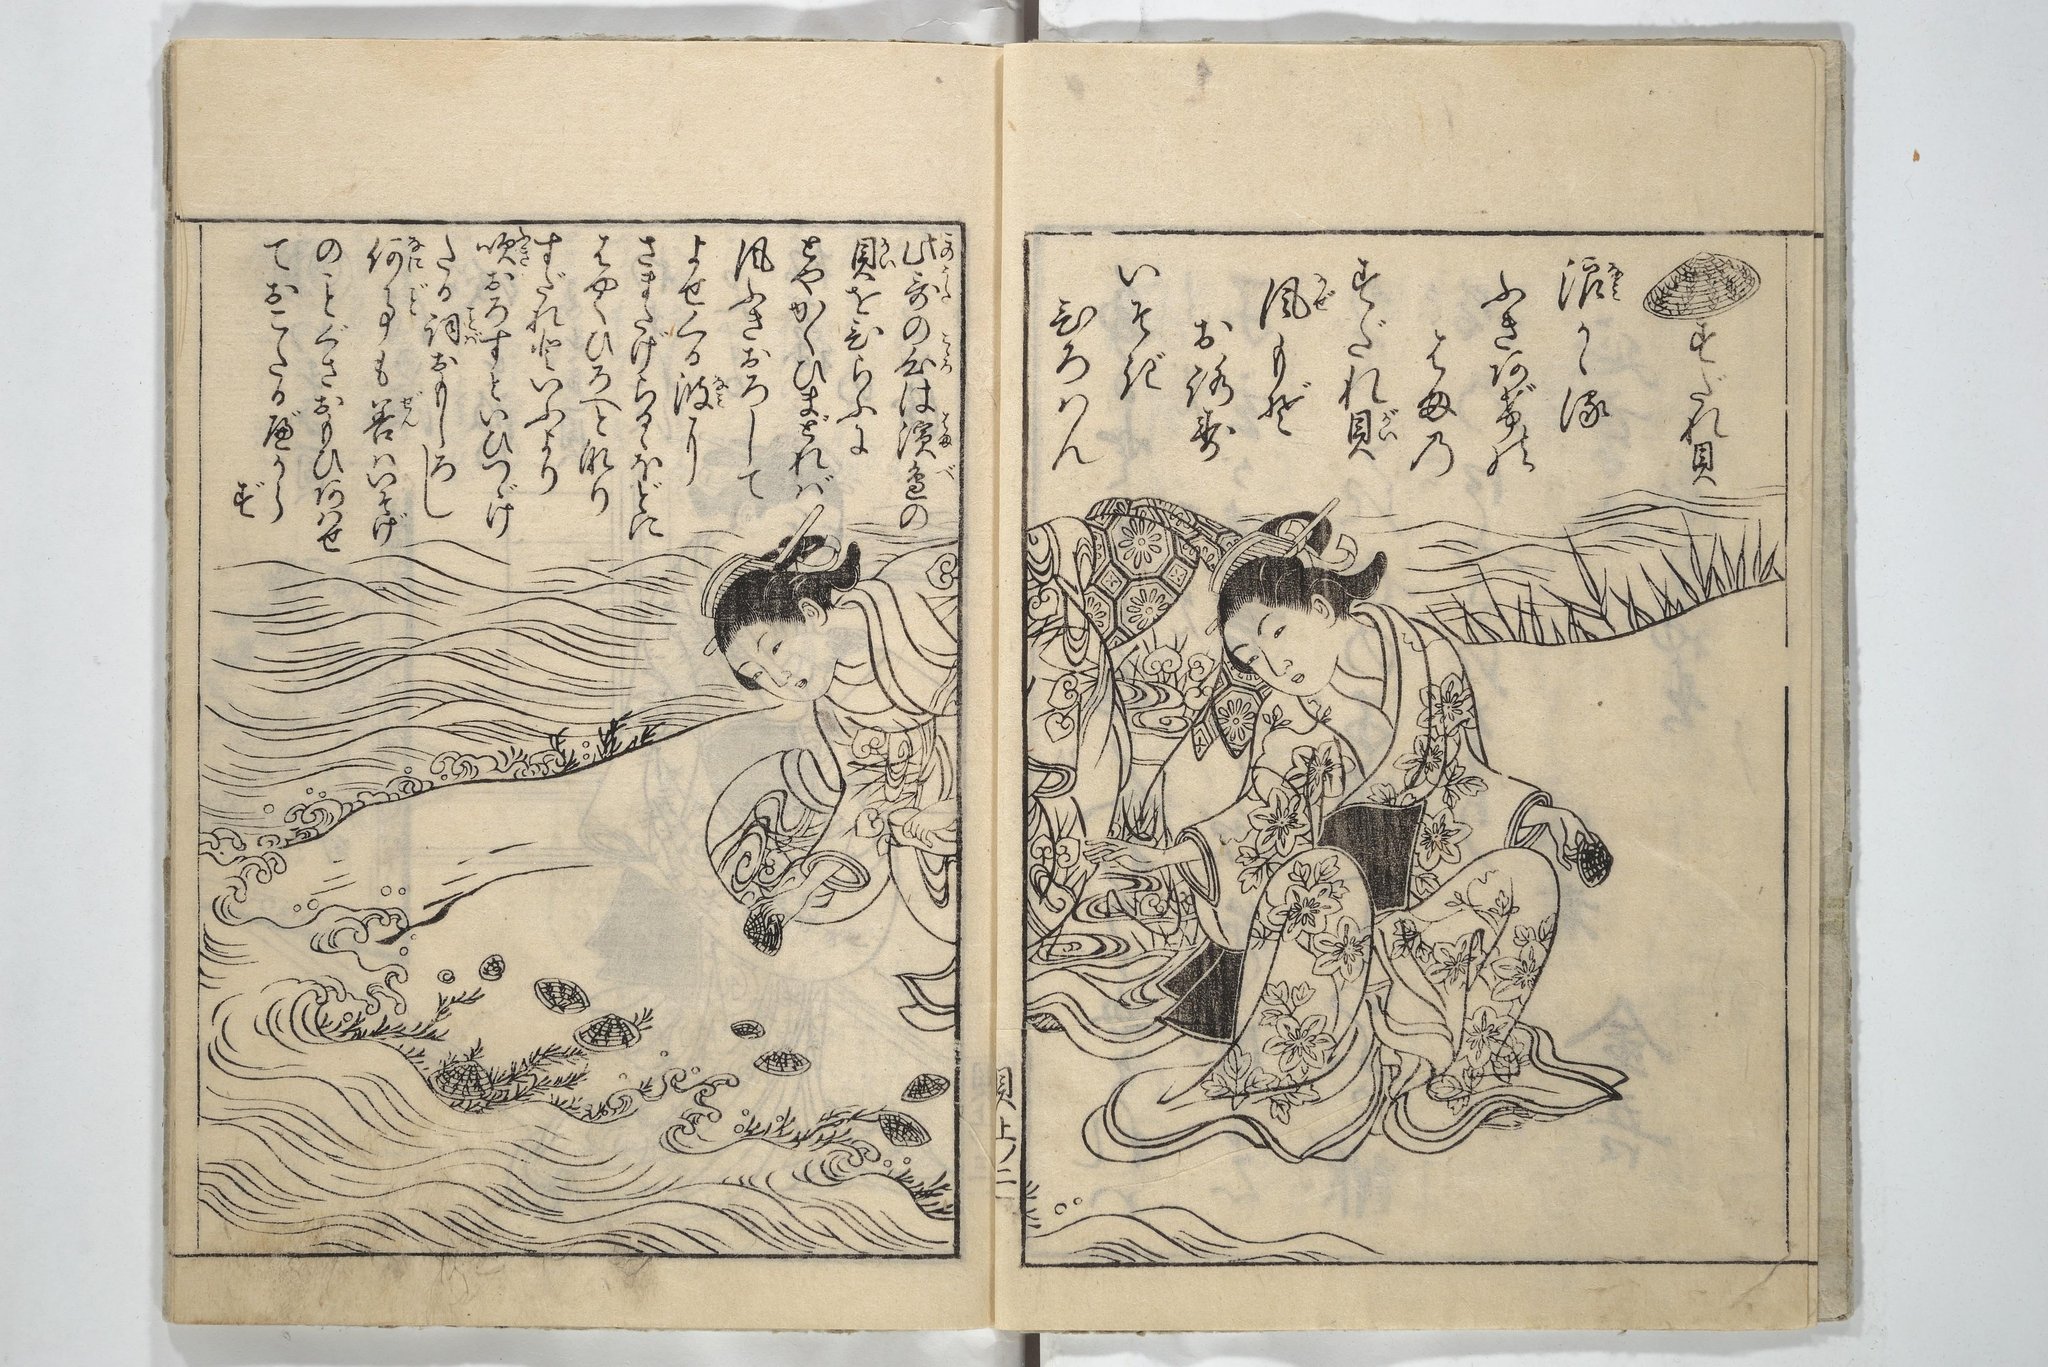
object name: illustrated book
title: Picture Book of Poems on Shells (Kyōkun chūkai ehon kai kasen) 教訓註解絵本貝歌仙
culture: japanese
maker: nishikawa sukenobu 西川祐信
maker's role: artist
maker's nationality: japanese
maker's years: 1671-1750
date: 1748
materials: ink, paper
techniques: woodblock print